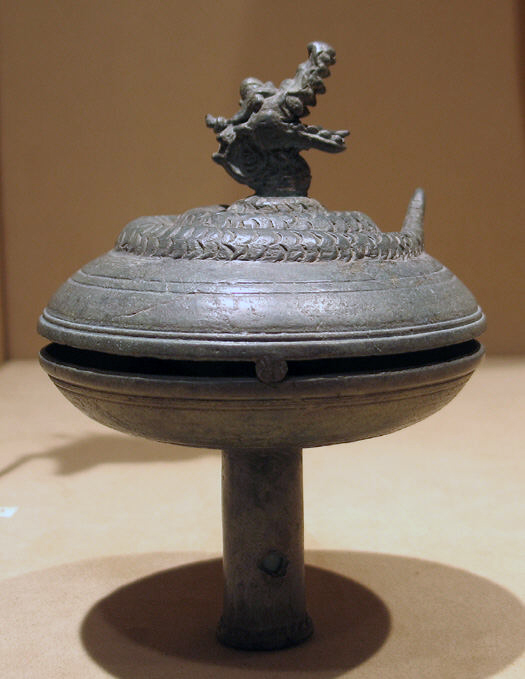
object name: rattle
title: Rattle with a Coiled Serpent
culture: indonesian, javanese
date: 1201-1400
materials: bronze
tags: musical instruments,snakes